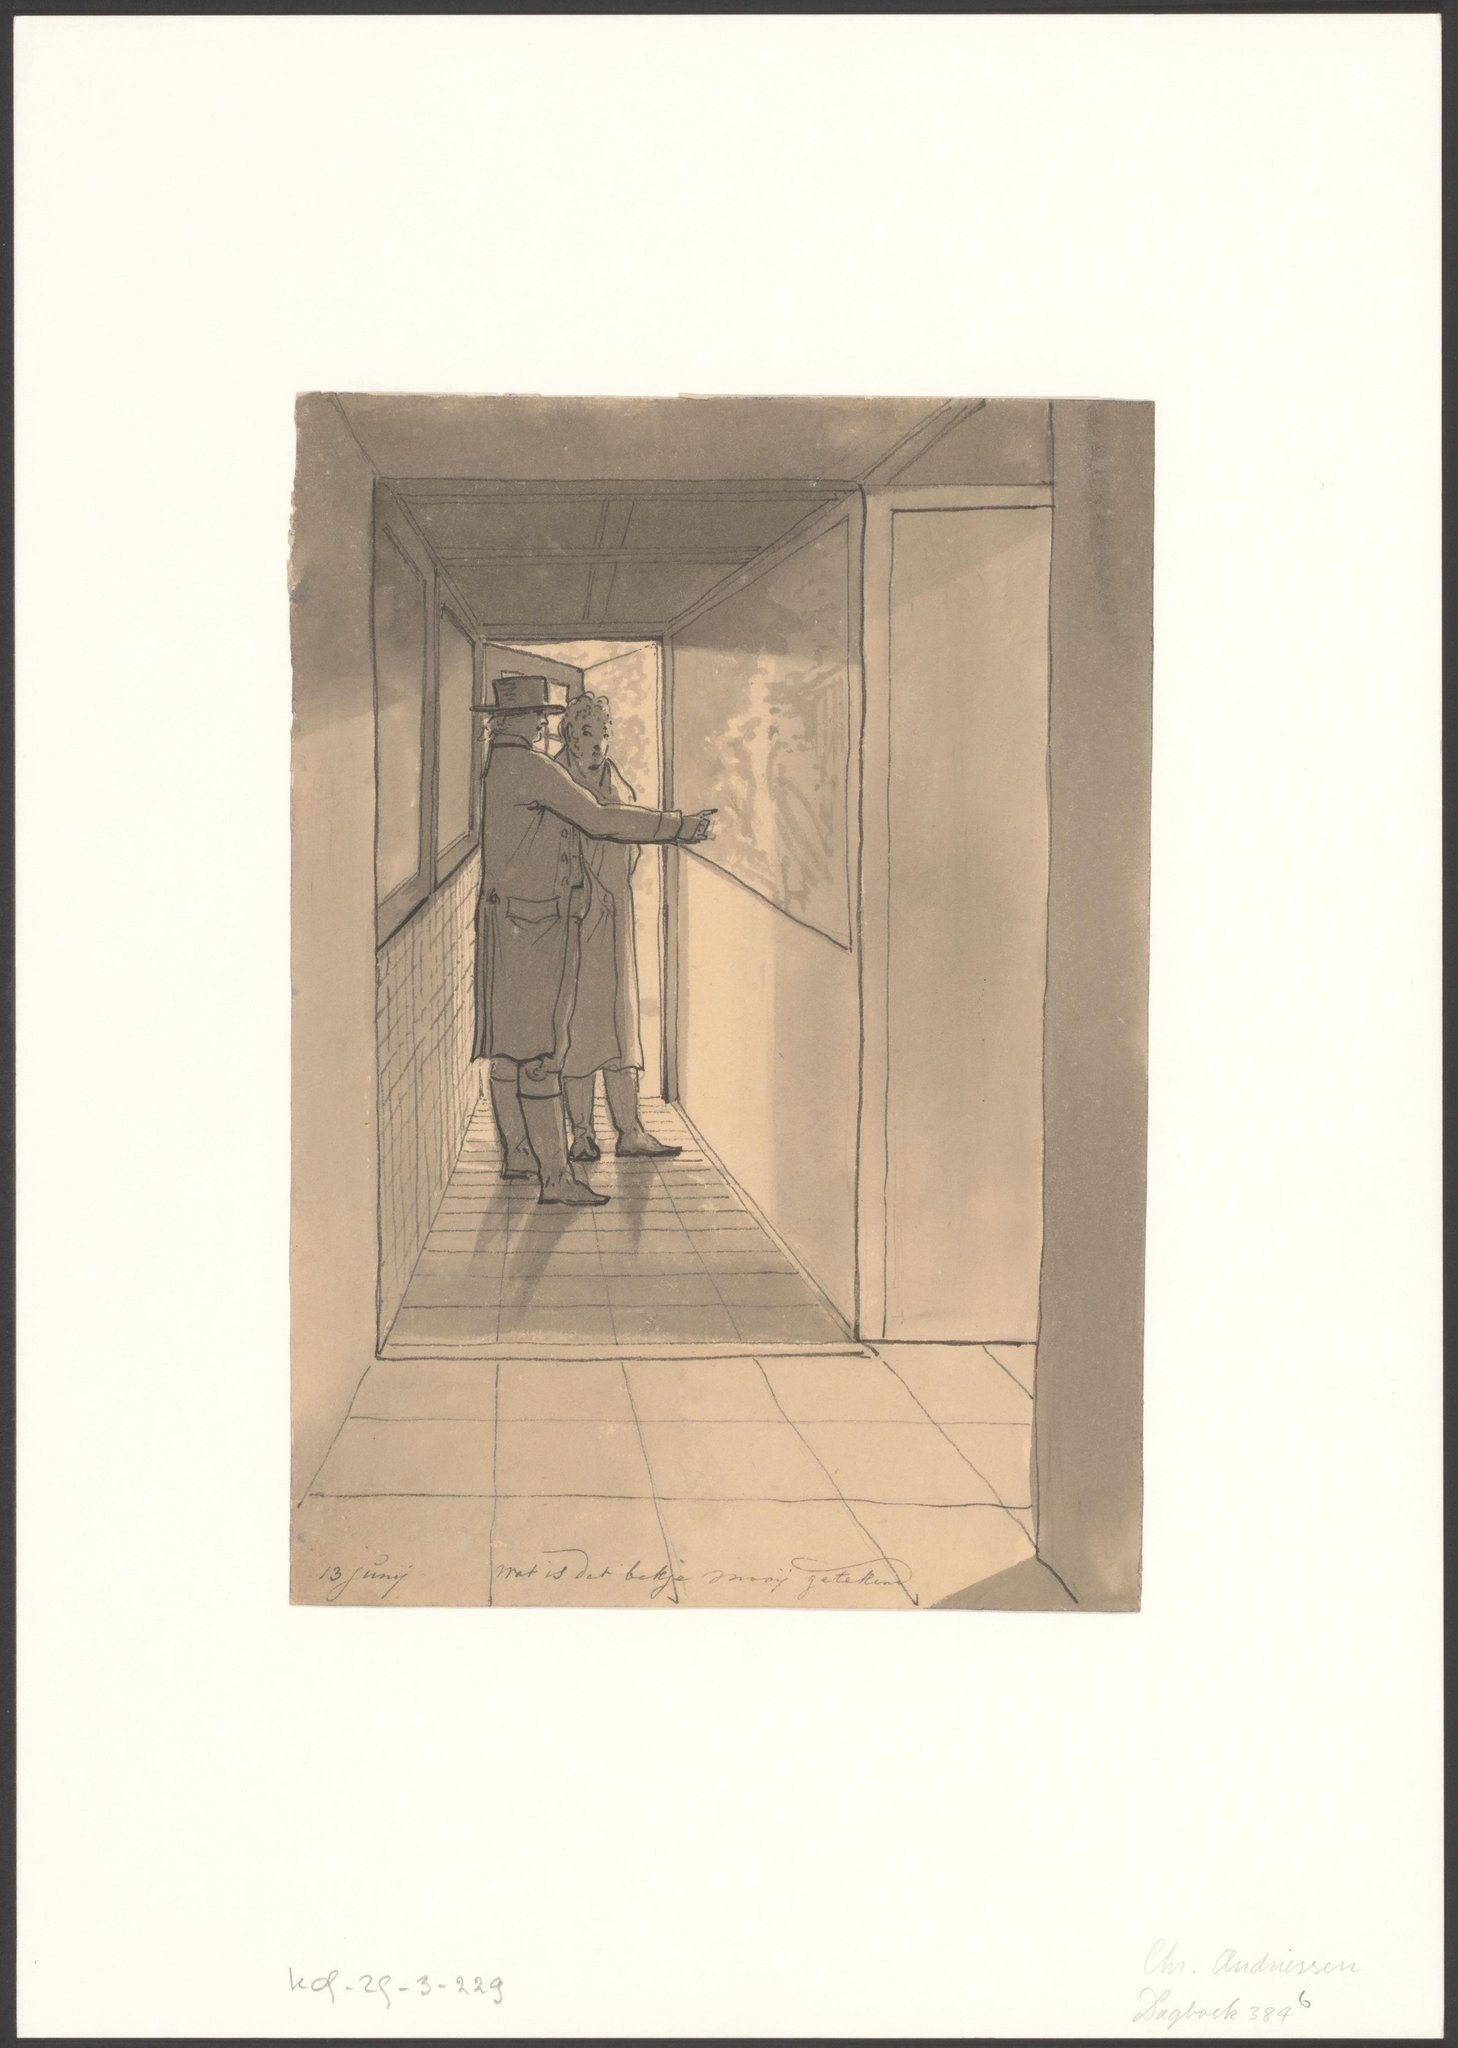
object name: drawing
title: Christiaan Andriessen bekijkt met iemand een tekening of schildering in een gang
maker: christiaan andriessen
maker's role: draughtsman, print maker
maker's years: 1775-1846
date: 1805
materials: ink, paper, pencil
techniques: brush, pen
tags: vestibule, hall, painting (including book-illumination, miniature-painting)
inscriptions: signature: ‘J Andriessen’, inscription: ‘13 junij wat is dat bekje mooij getekend’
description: Dagboekblad uit het getekende dagboek dat Christiaan Andriessen bijhield van 1805 tot en met 1808.